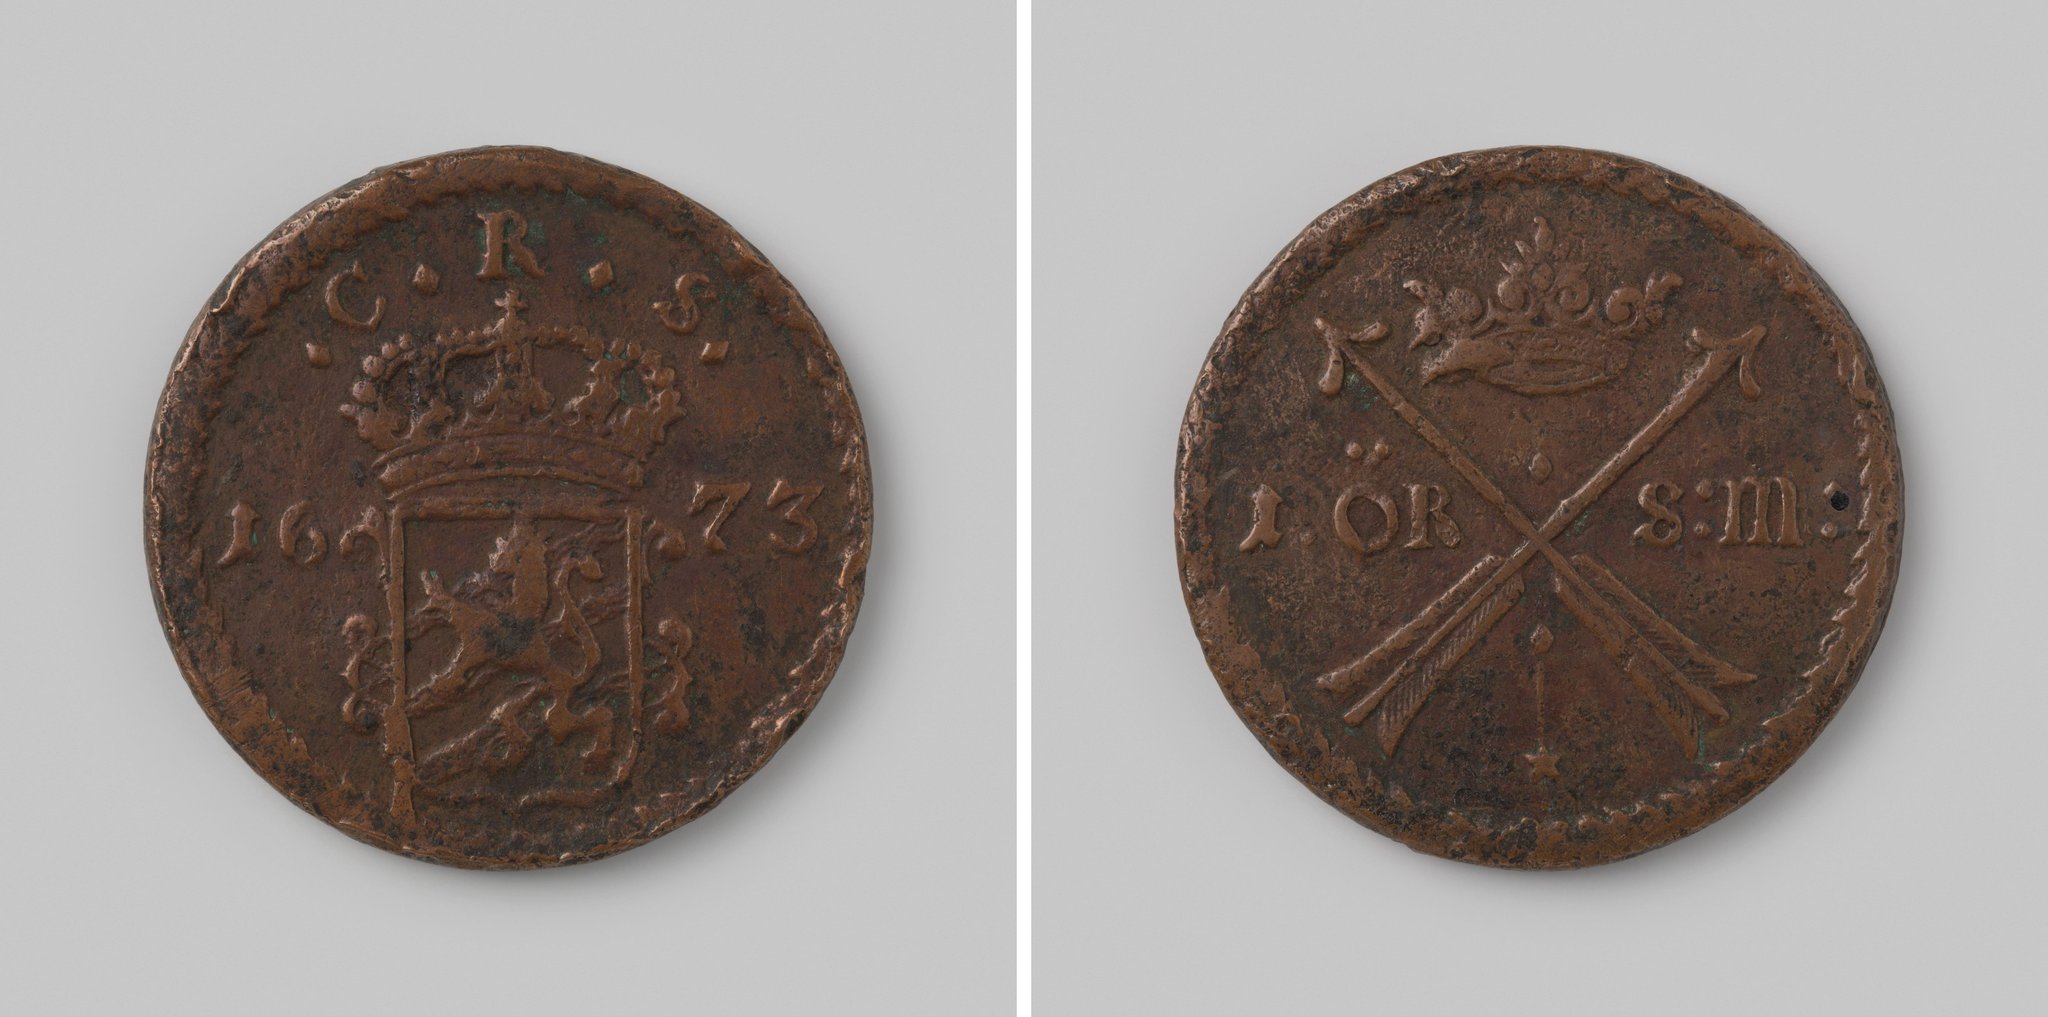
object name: coin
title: Zweden, Karel XI, öre S[ilver] M[ynt], 1673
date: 1673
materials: copper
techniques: striking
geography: slot rörstrand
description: Koperen munt. Voorzijde: tussen jaartal gekroond wapenschild. Daarboven letters C,R en S. Keerzijde: twee gekruiste pijlen, waarboven kroon en waaronder kleine ster. Waarde-aanduiding in veld. Gladde rand.